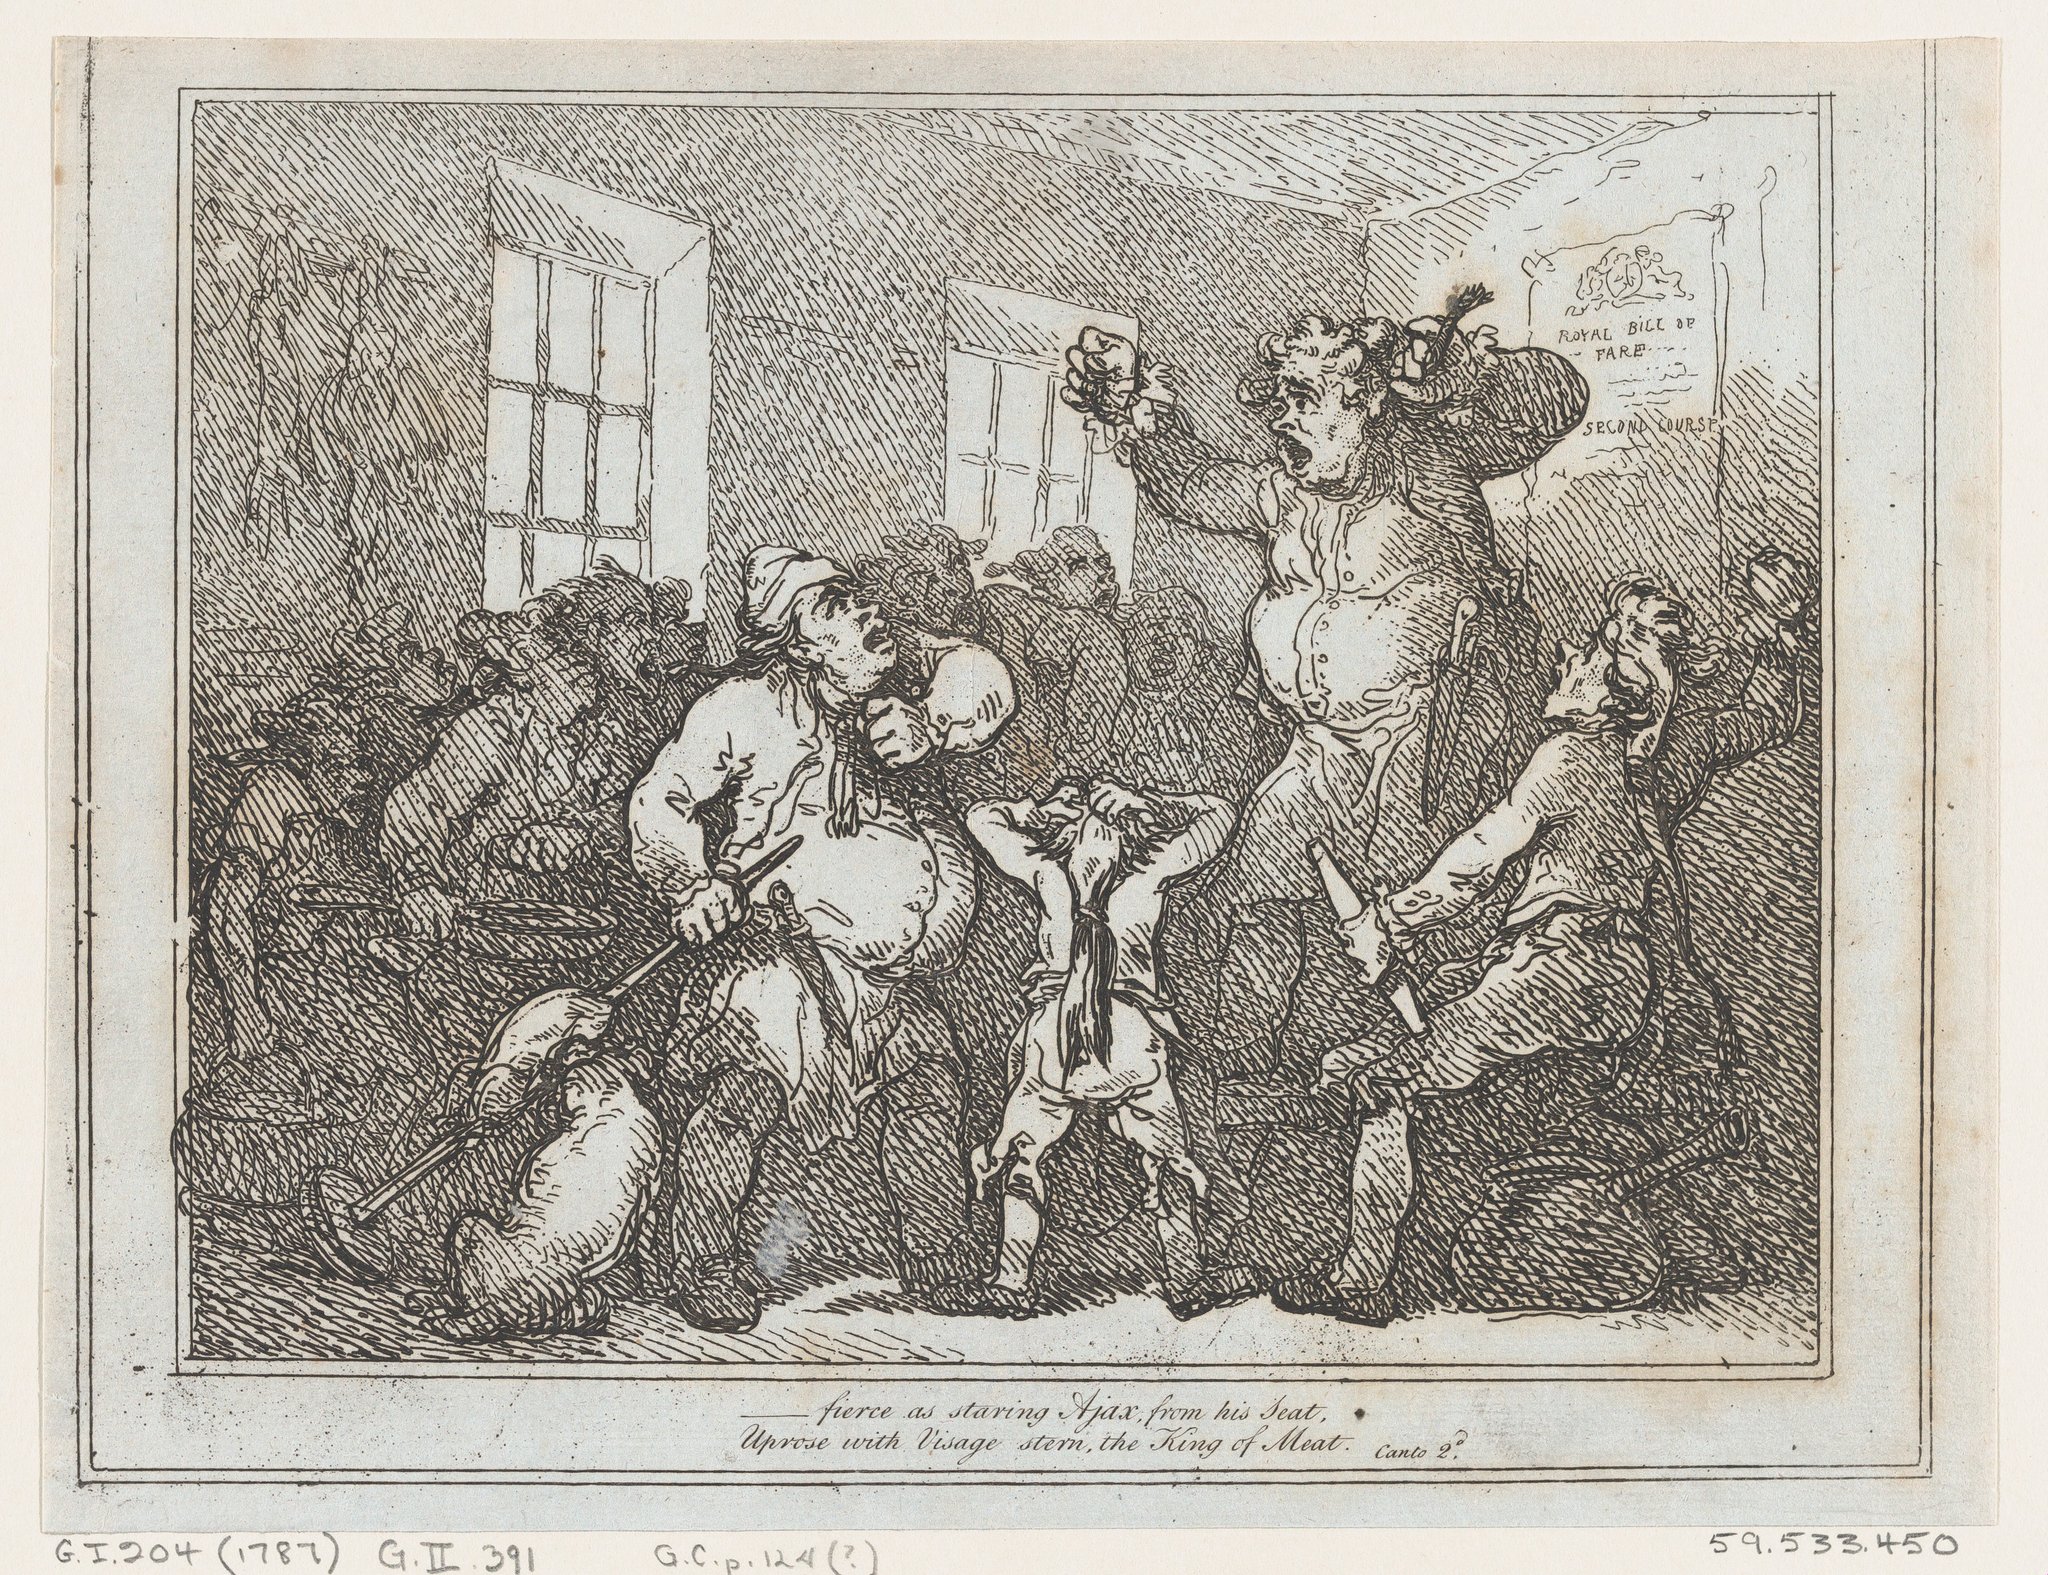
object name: print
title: Fierce as staring Ajax from this seat...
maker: thomas rowlandson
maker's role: artist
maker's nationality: british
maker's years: 1757-1827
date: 1787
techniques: etching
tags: satire,men,dogs